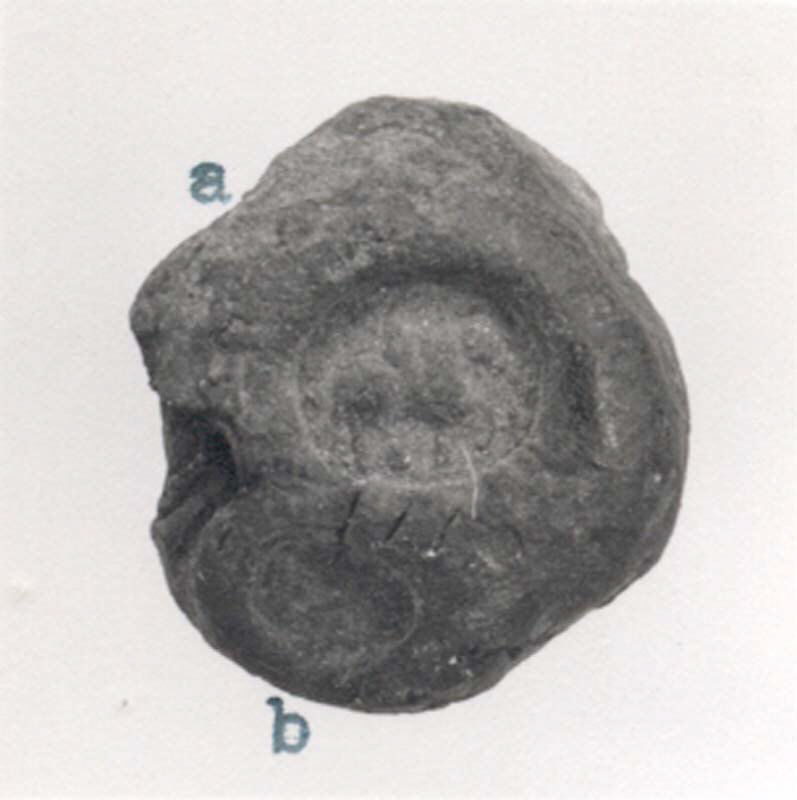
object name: sealing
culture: sasanian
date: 601-700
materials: clay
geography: iran